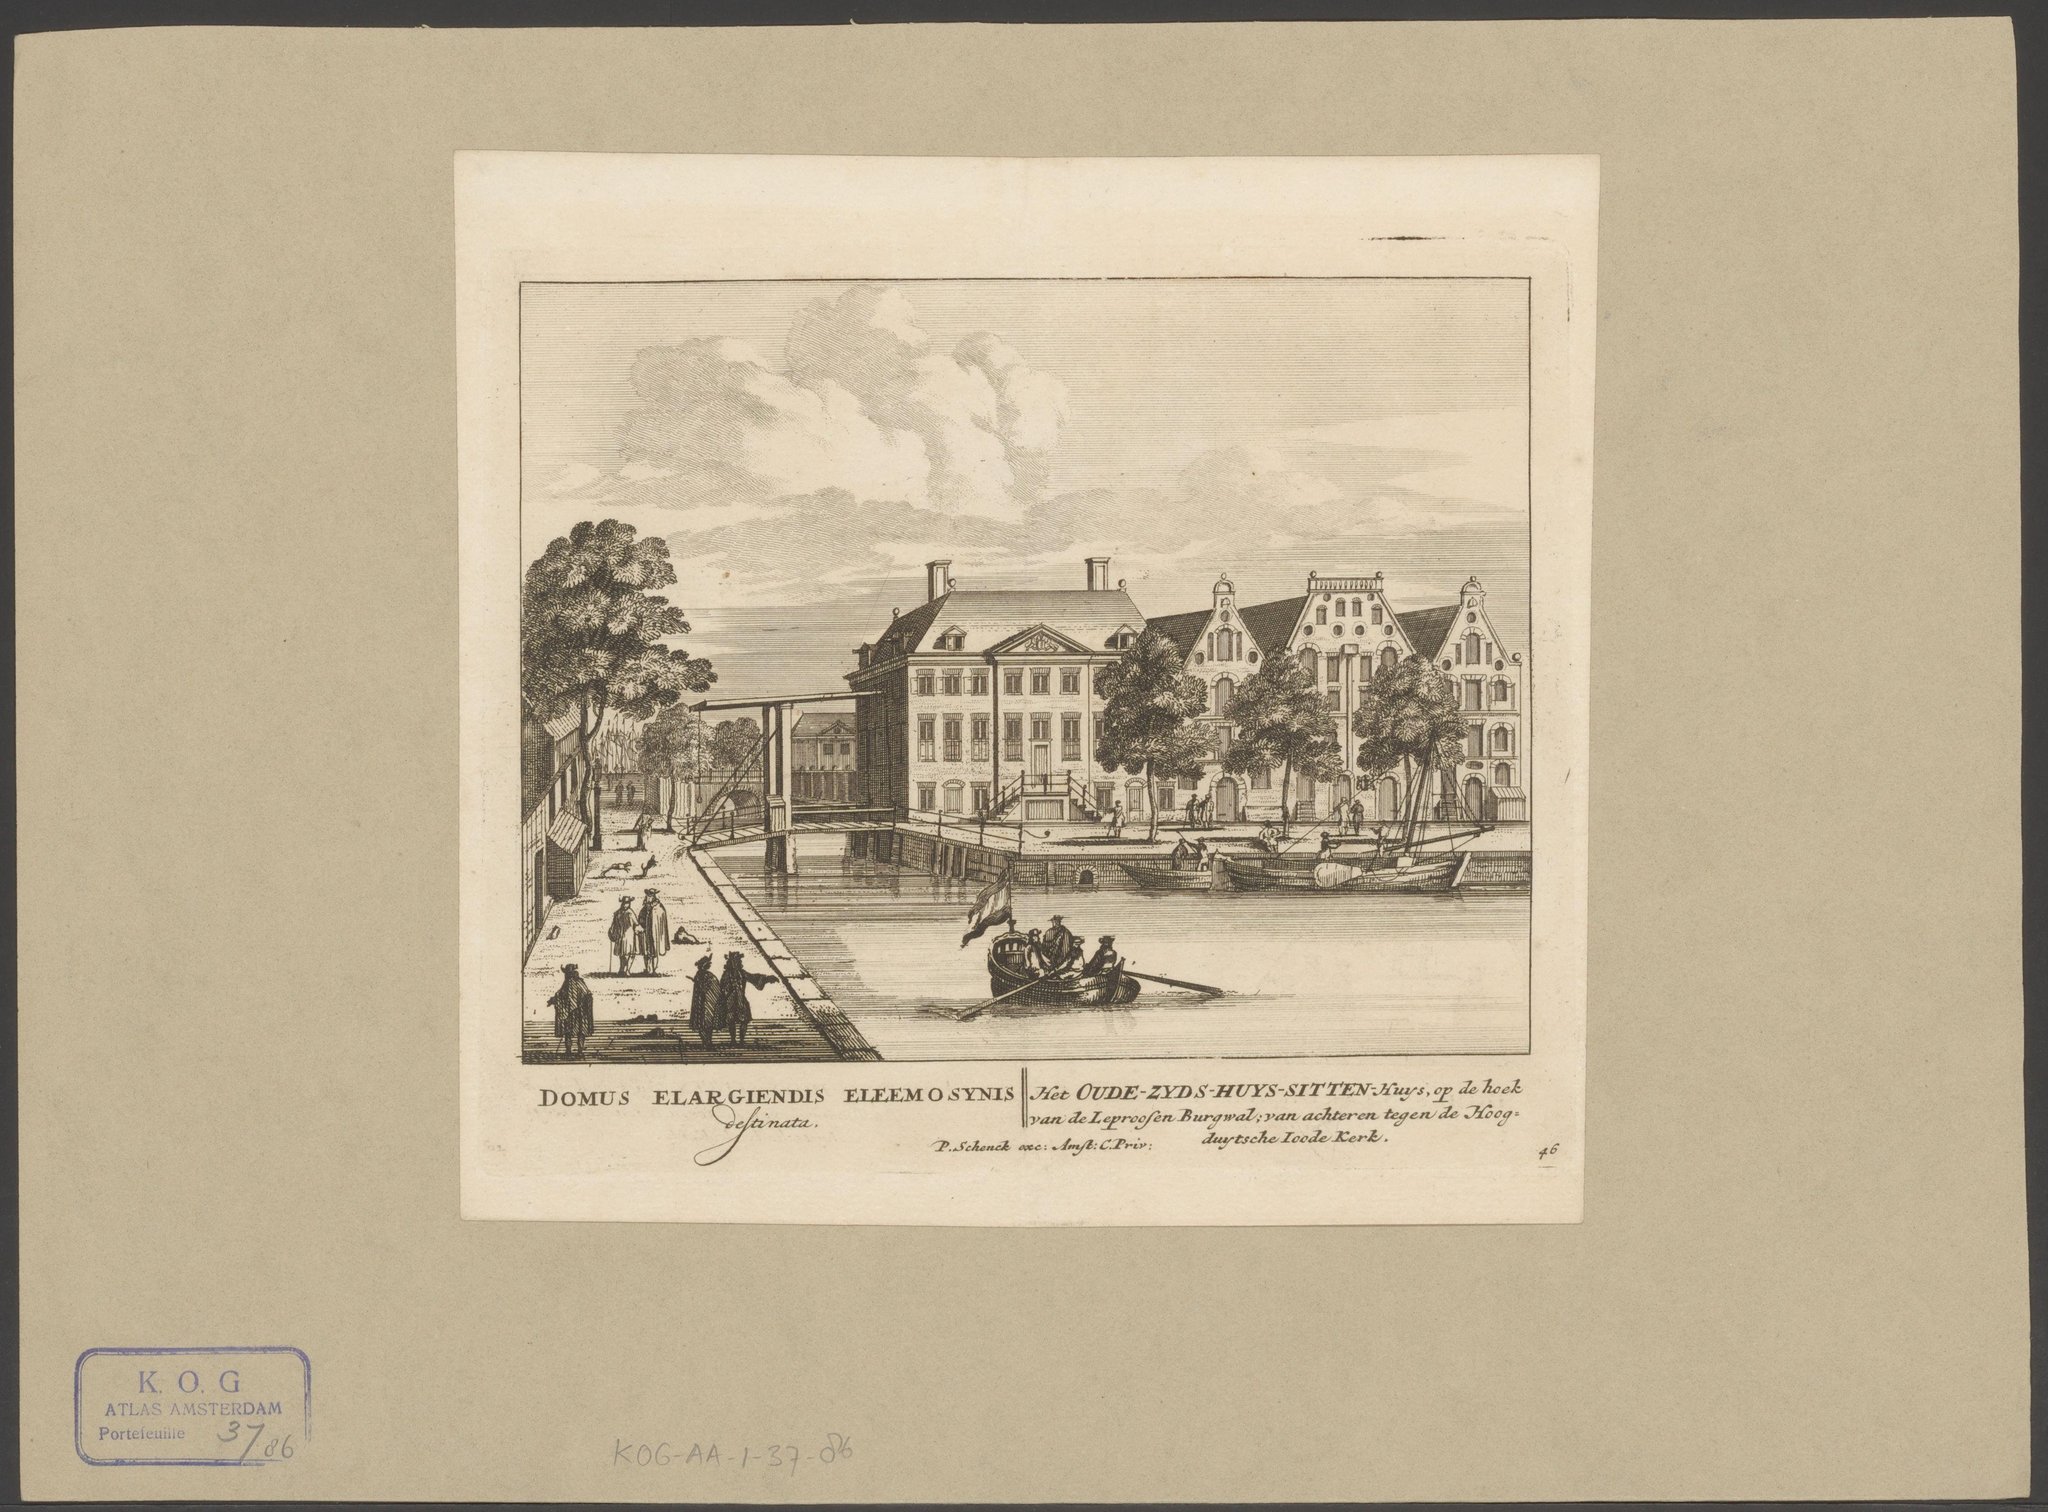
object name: print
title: Gezicht op het Oudezijds Huiszittenhuis te Amsterdam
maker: Anonymous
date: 1710-1711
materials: paper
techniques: engraving, etching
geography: northern netherlands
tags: poorhouse, ships (in general), canals, waters (in city) (+ city(-scape) with figures, staffage)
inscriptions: collector's mark: Lugt 1641b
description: Prent mogelijk uit: 100 Afbeeldinge der voornaamste gebouwen van Amsterdam. Amsterdam: Pieter Schenk (I), s.a. [1710-1711]. Of uit: 100 Afbeeldinge der voornaamste gebouwen van Amsterdam. Amsterdam: Barent Greve, s.a. [1757-1766]. In de tweede uitgave, uitgegeven door Barent Greve, is alleen de titelprent aangepast. De overige prenten zijn onveranderd gebleven.